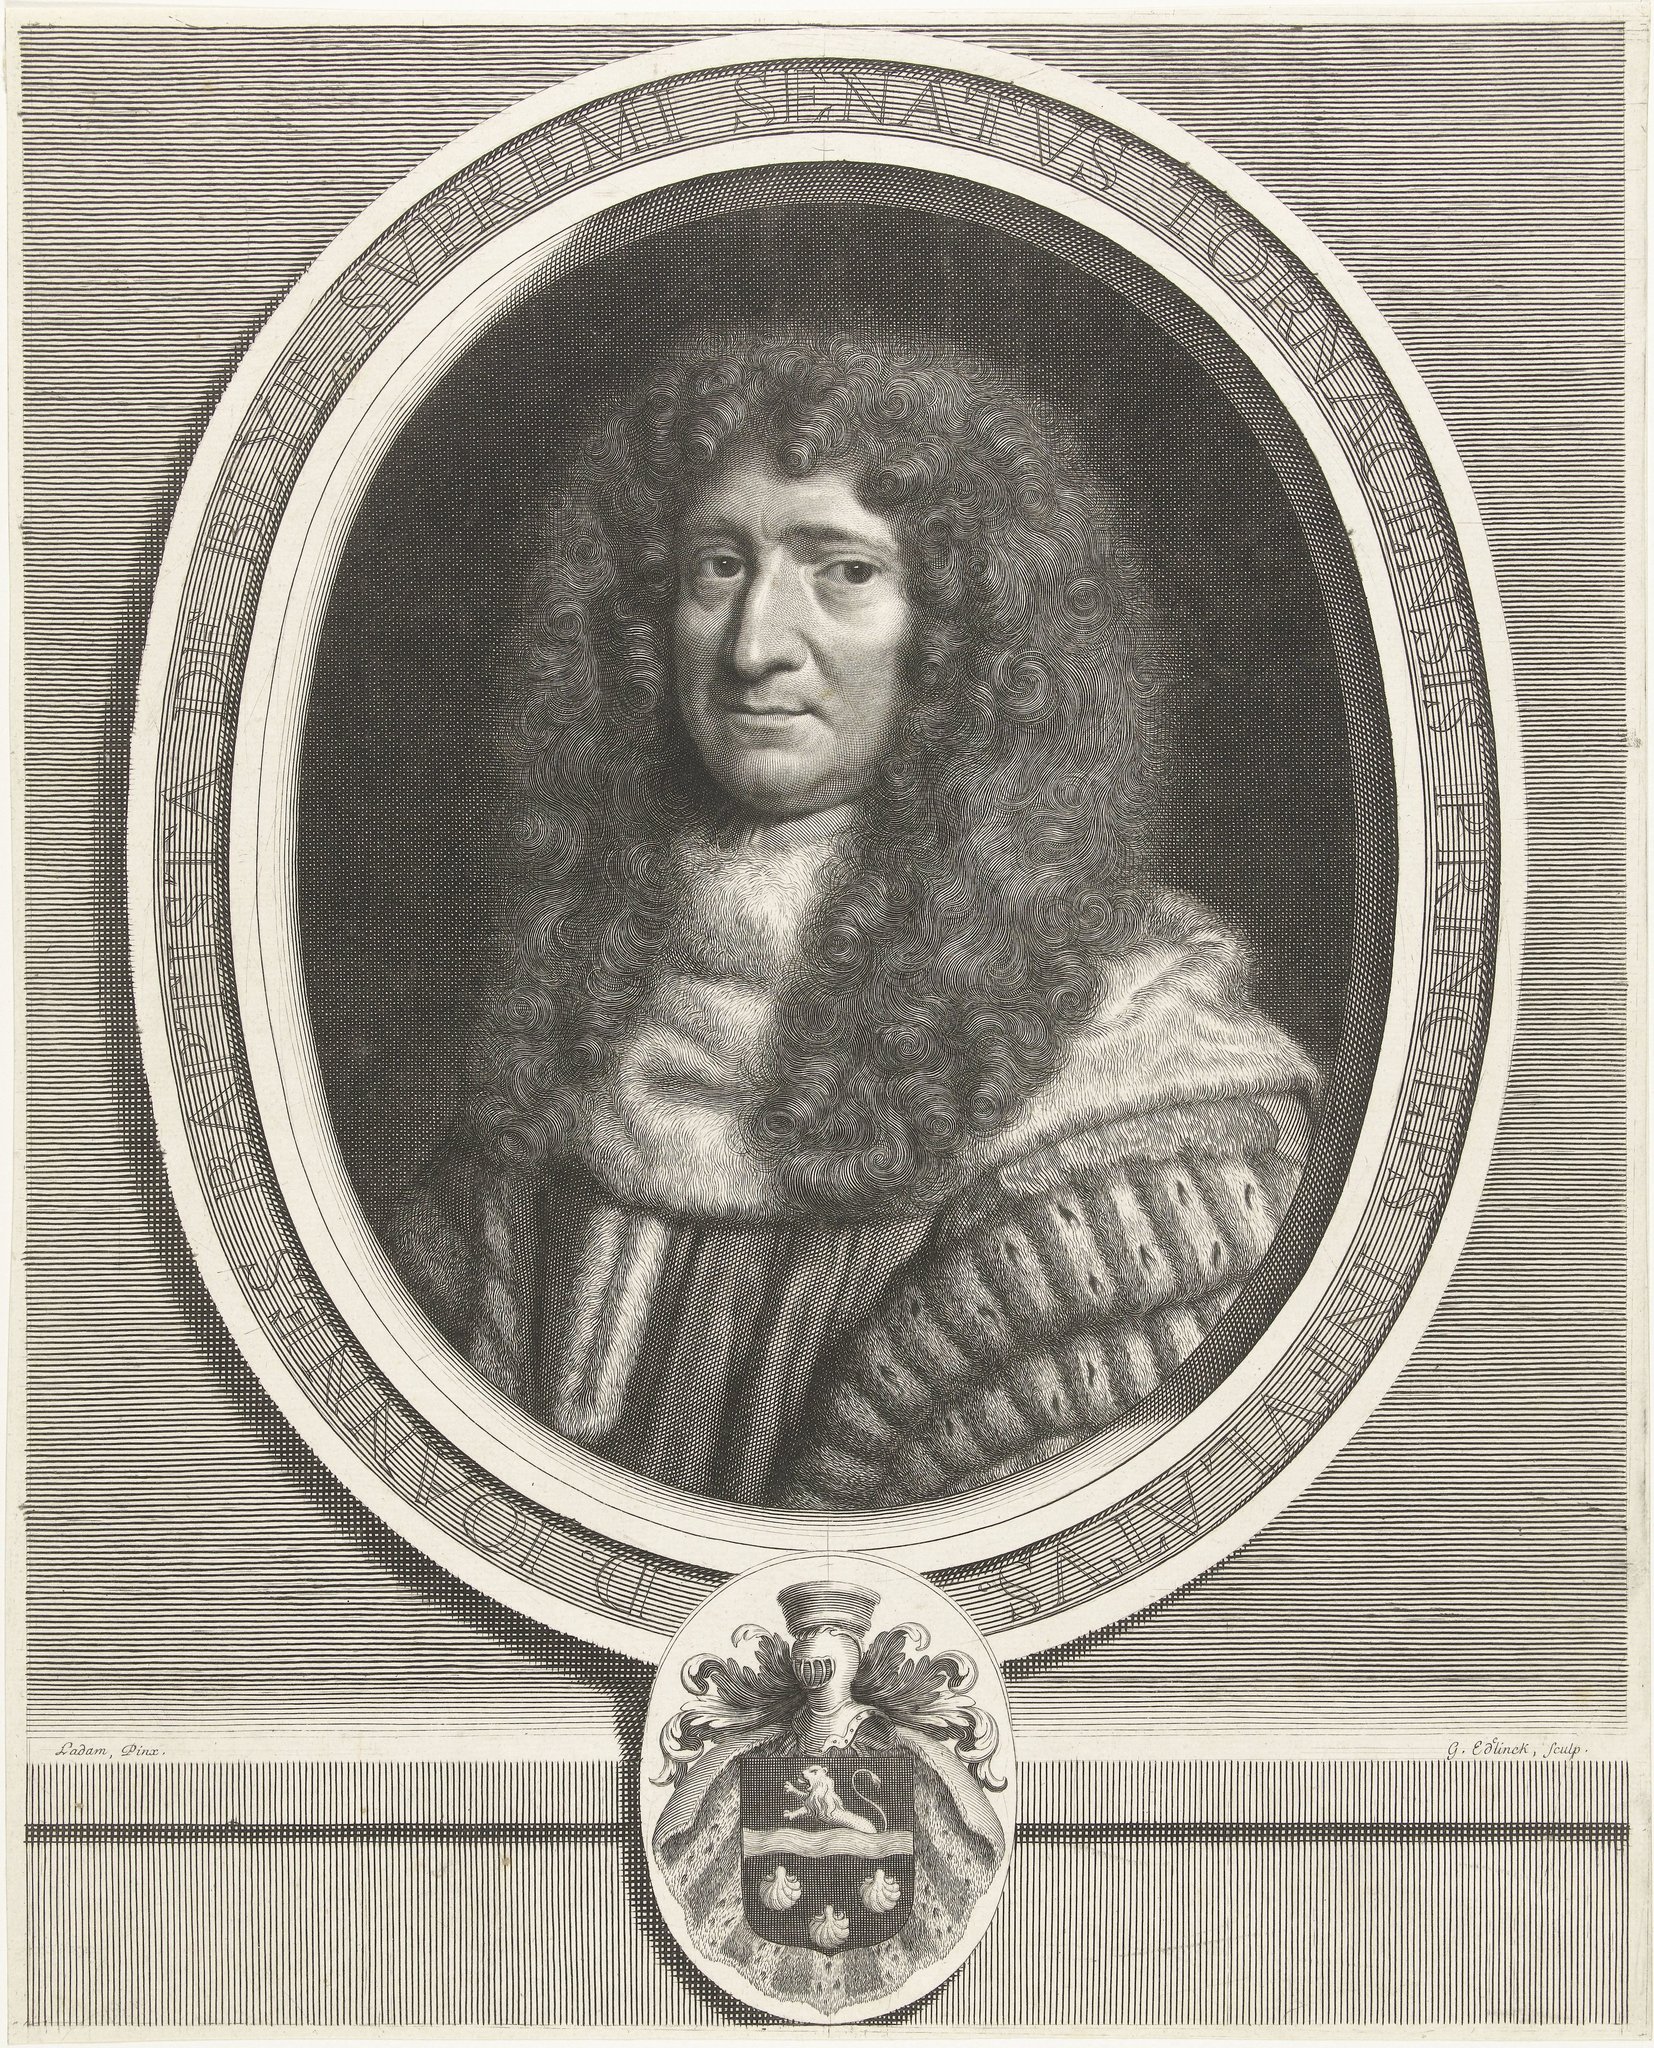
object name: print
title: Portret van Jean-Baptiste de Blye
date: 1652-1707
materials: paper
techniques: engraving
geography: france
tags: jean-baptiste de blye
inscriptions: collector's mark: Lugt 1008, collector's mark: Lugt 2161, collector's mark: Lugt 2228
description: Portret van Jean-Baptiste de Blye, de eerste president van het parlement van Tournay, afgebeeld in ovale omlijsting met wapen.